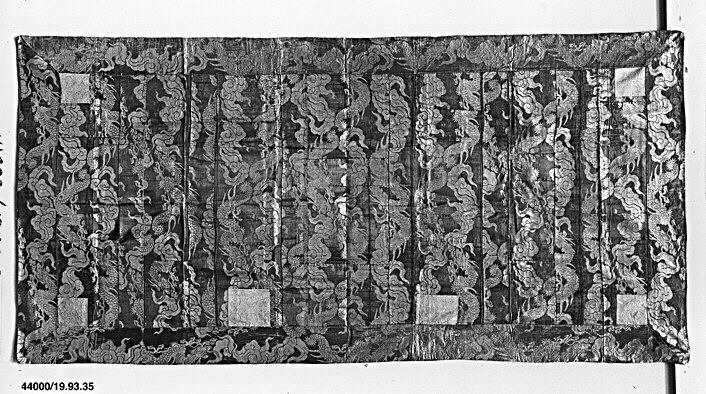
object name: robe, priest's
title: Priest's Robe (Shichijō)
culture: japanese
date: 1624-1644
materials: metal thread, silk